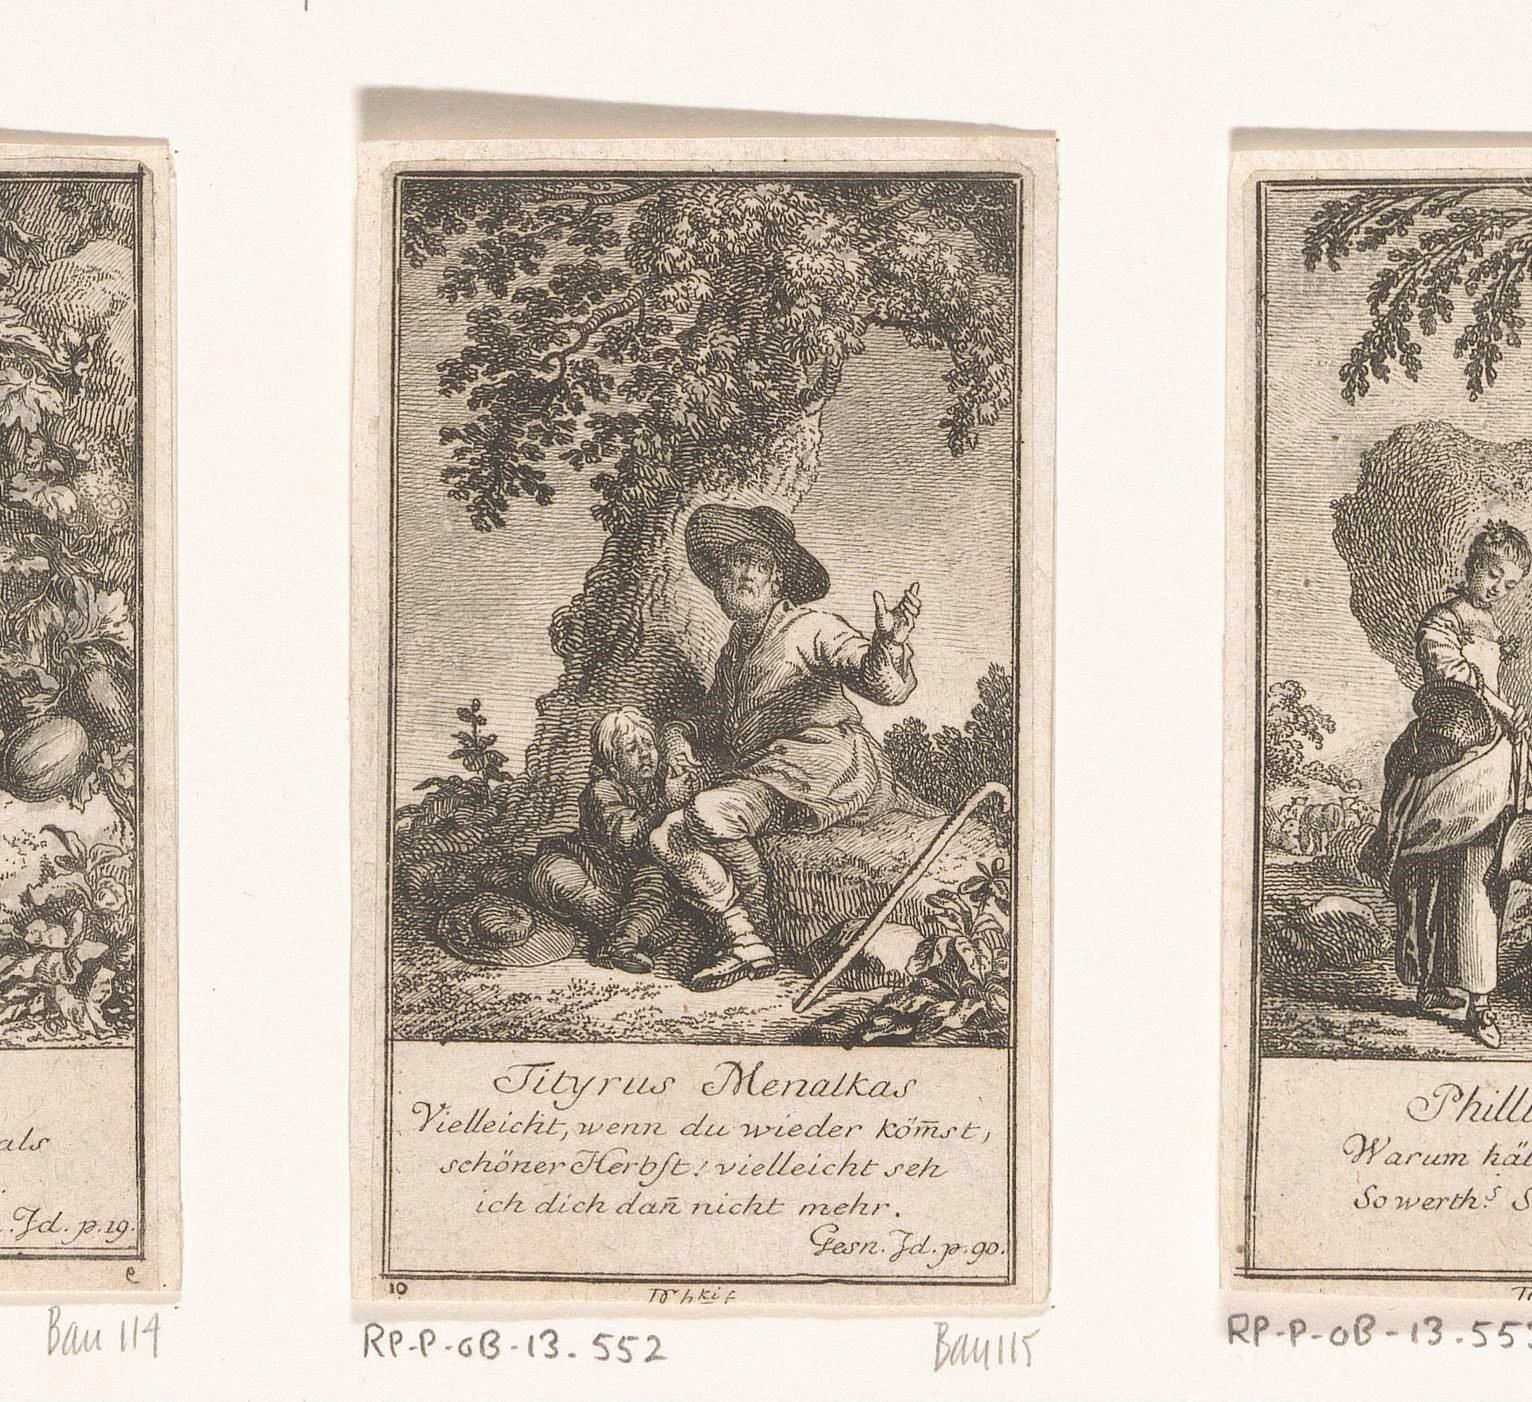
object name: print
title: Tityrus en Menalkas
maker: daniel nikolaus chodowiecki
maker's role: draughtsman, print maker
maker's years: 1726-1801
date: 1771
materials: paper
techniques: etching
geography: berlin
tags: painter, print maker, salomon gessner, literature, father and son(s) (family group), pastorals, arcadian scenes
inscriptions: collector's mark: Lugt 2228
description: Tiende prent afkomstig uit een serie met twaalf scènes die 'Idyllen' van Salomon Gessner illustreren. De twaalf scènes werden samen op een plaat geëtst. De serie is gebruikt als illustratie in: 'Berliner genealogischen Calender auf das Jahr 1773'.